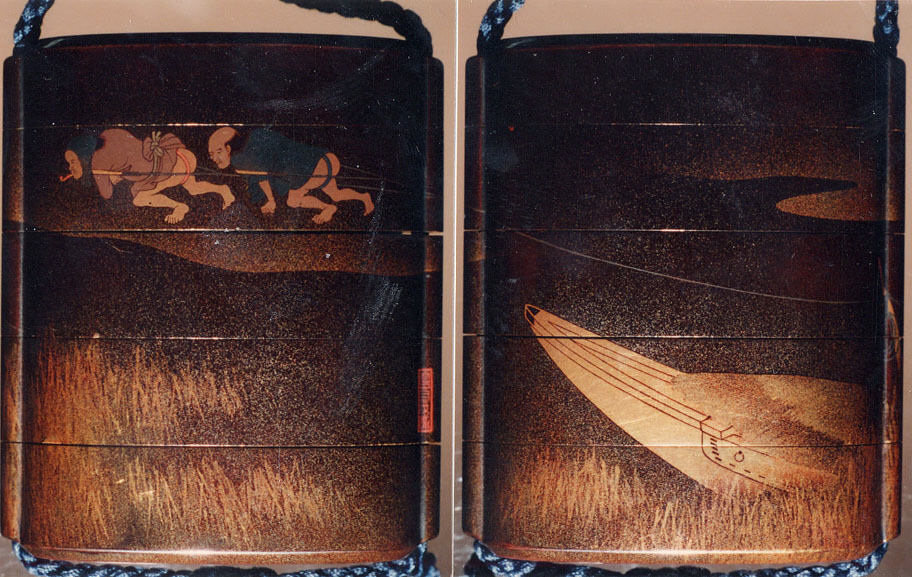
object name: inrō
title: Case (Inrō) with Design of Two Men Pulling a Boat Filled with Rice Sheaves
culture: japanese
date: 1701-1900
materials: gold, lacquer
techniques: fundame, roiro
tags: men,boats